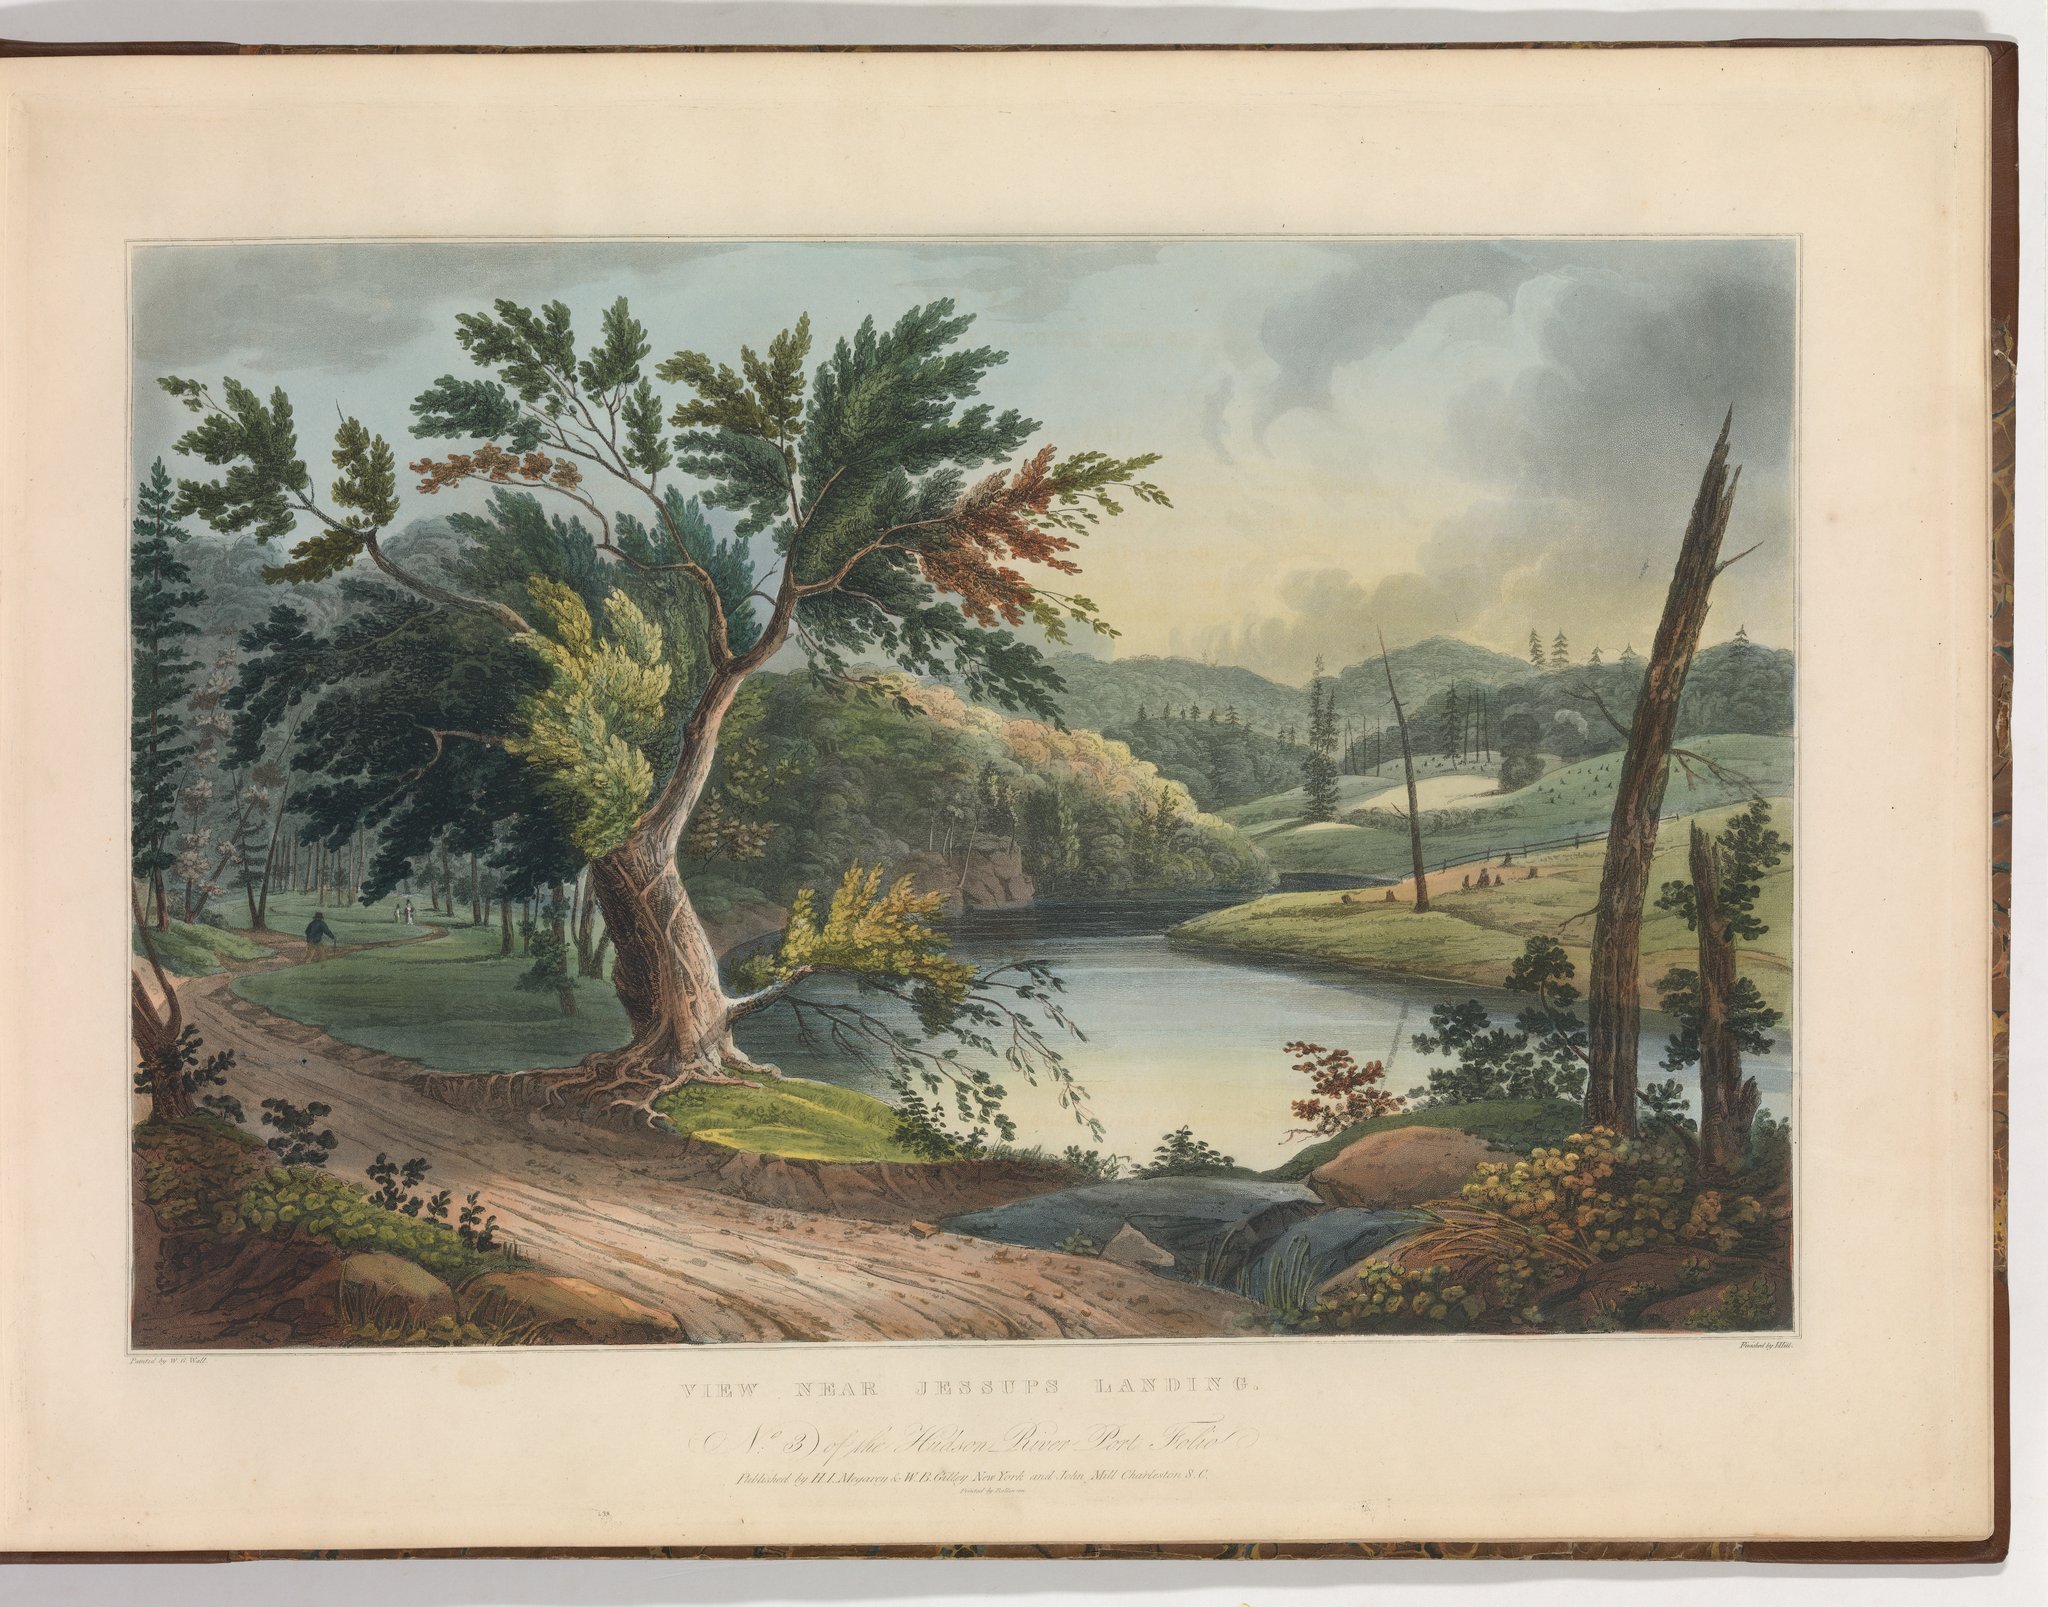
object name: print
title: View Near Jessup's Landing (No. 3 of The Hudson River Portfolio)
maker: john rubens smith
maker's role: etcher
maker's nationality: american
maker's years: 1775-1849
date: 1821-1822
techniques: aquatint, hand coloring, printing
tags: rivers,hills,landscapes